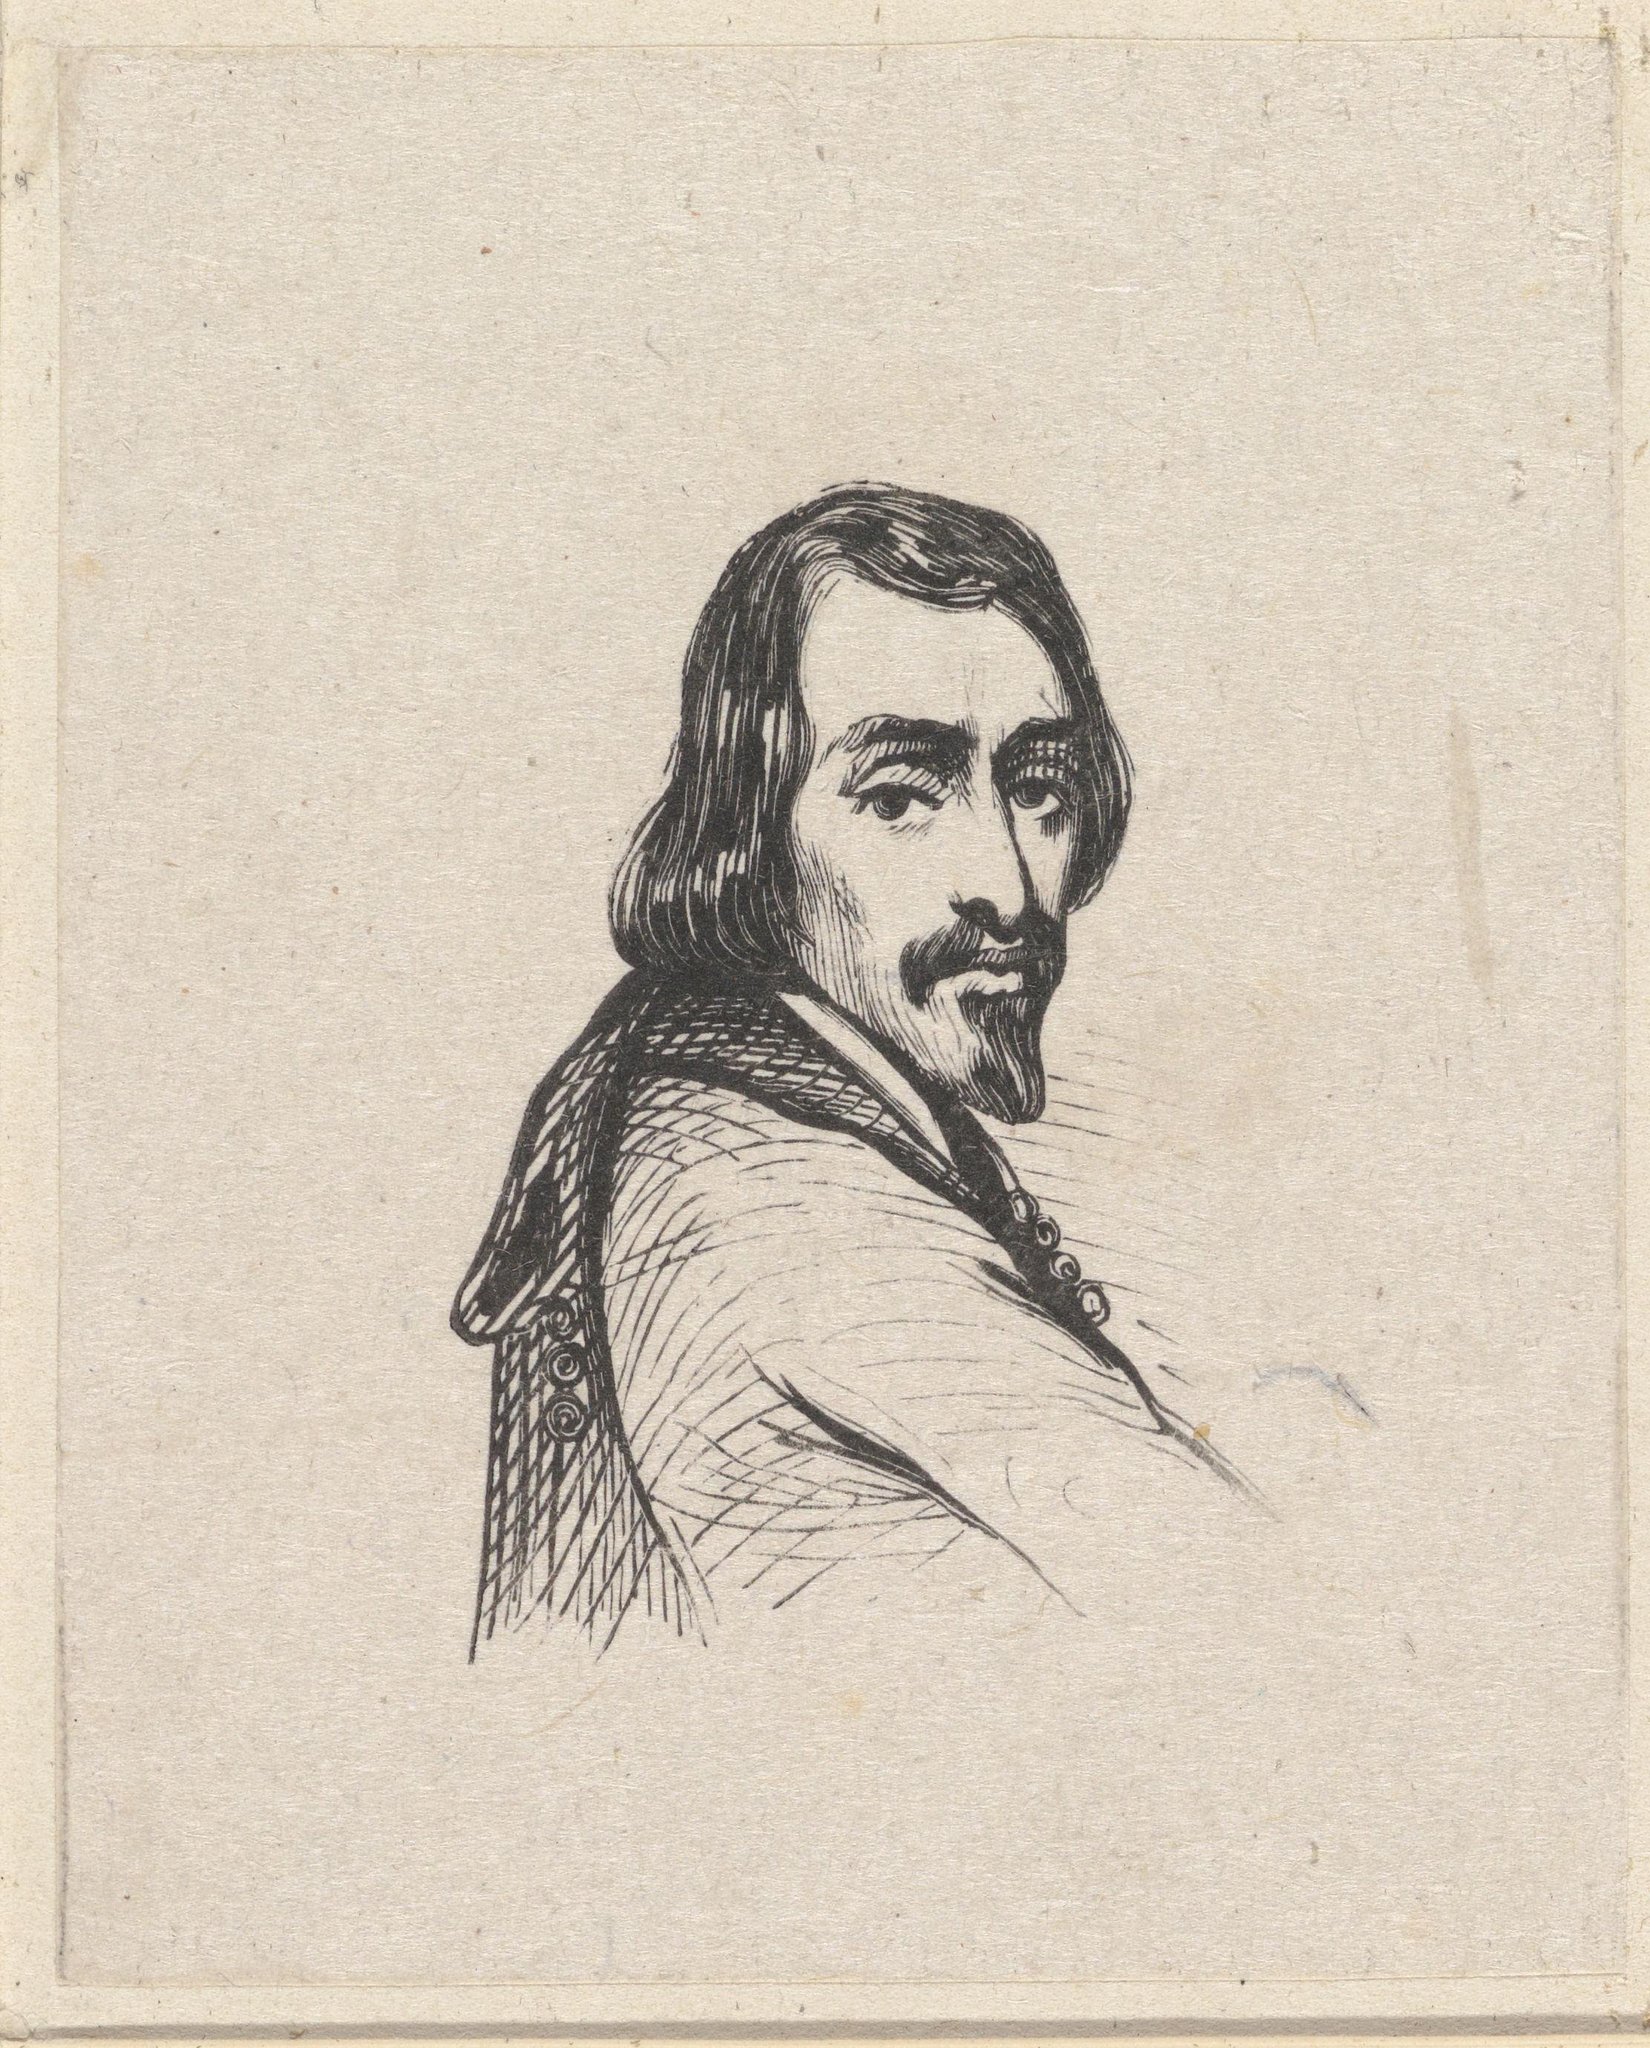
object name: print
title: Portret van François André Durlet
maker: Anonymous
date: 1841-1842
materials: paper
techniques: engraving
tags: draughtsman, franciscus andreas durlet, historical persons, portrait, self-portrait of painter, portrait, self-portrait of artist, portrait, self-portrait of draughtsman